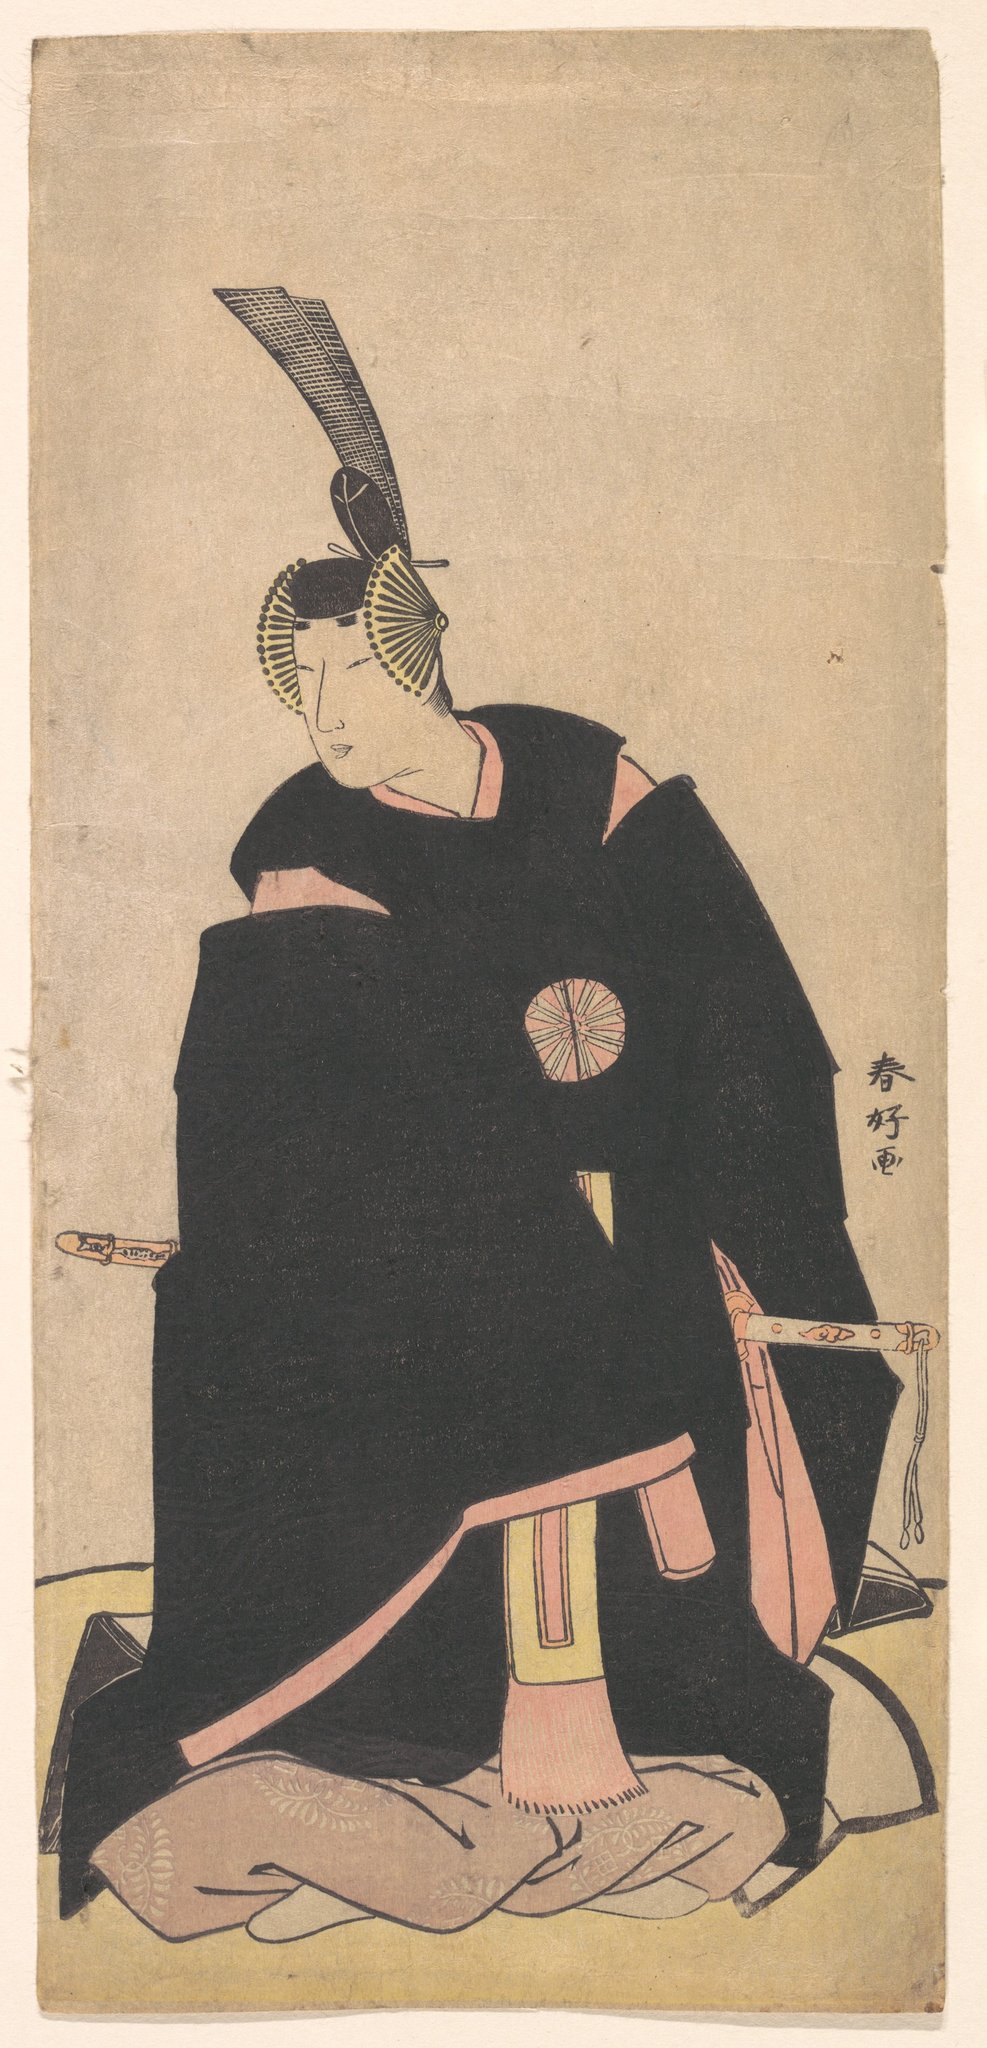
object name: print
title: The Actor Nakamura Tomijuro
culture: japanese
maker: katsukawa shunkō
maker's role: artist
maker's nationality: japanese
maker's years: 1743-1812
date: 1790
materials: ink, paper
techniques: woodblock print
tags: men,actors